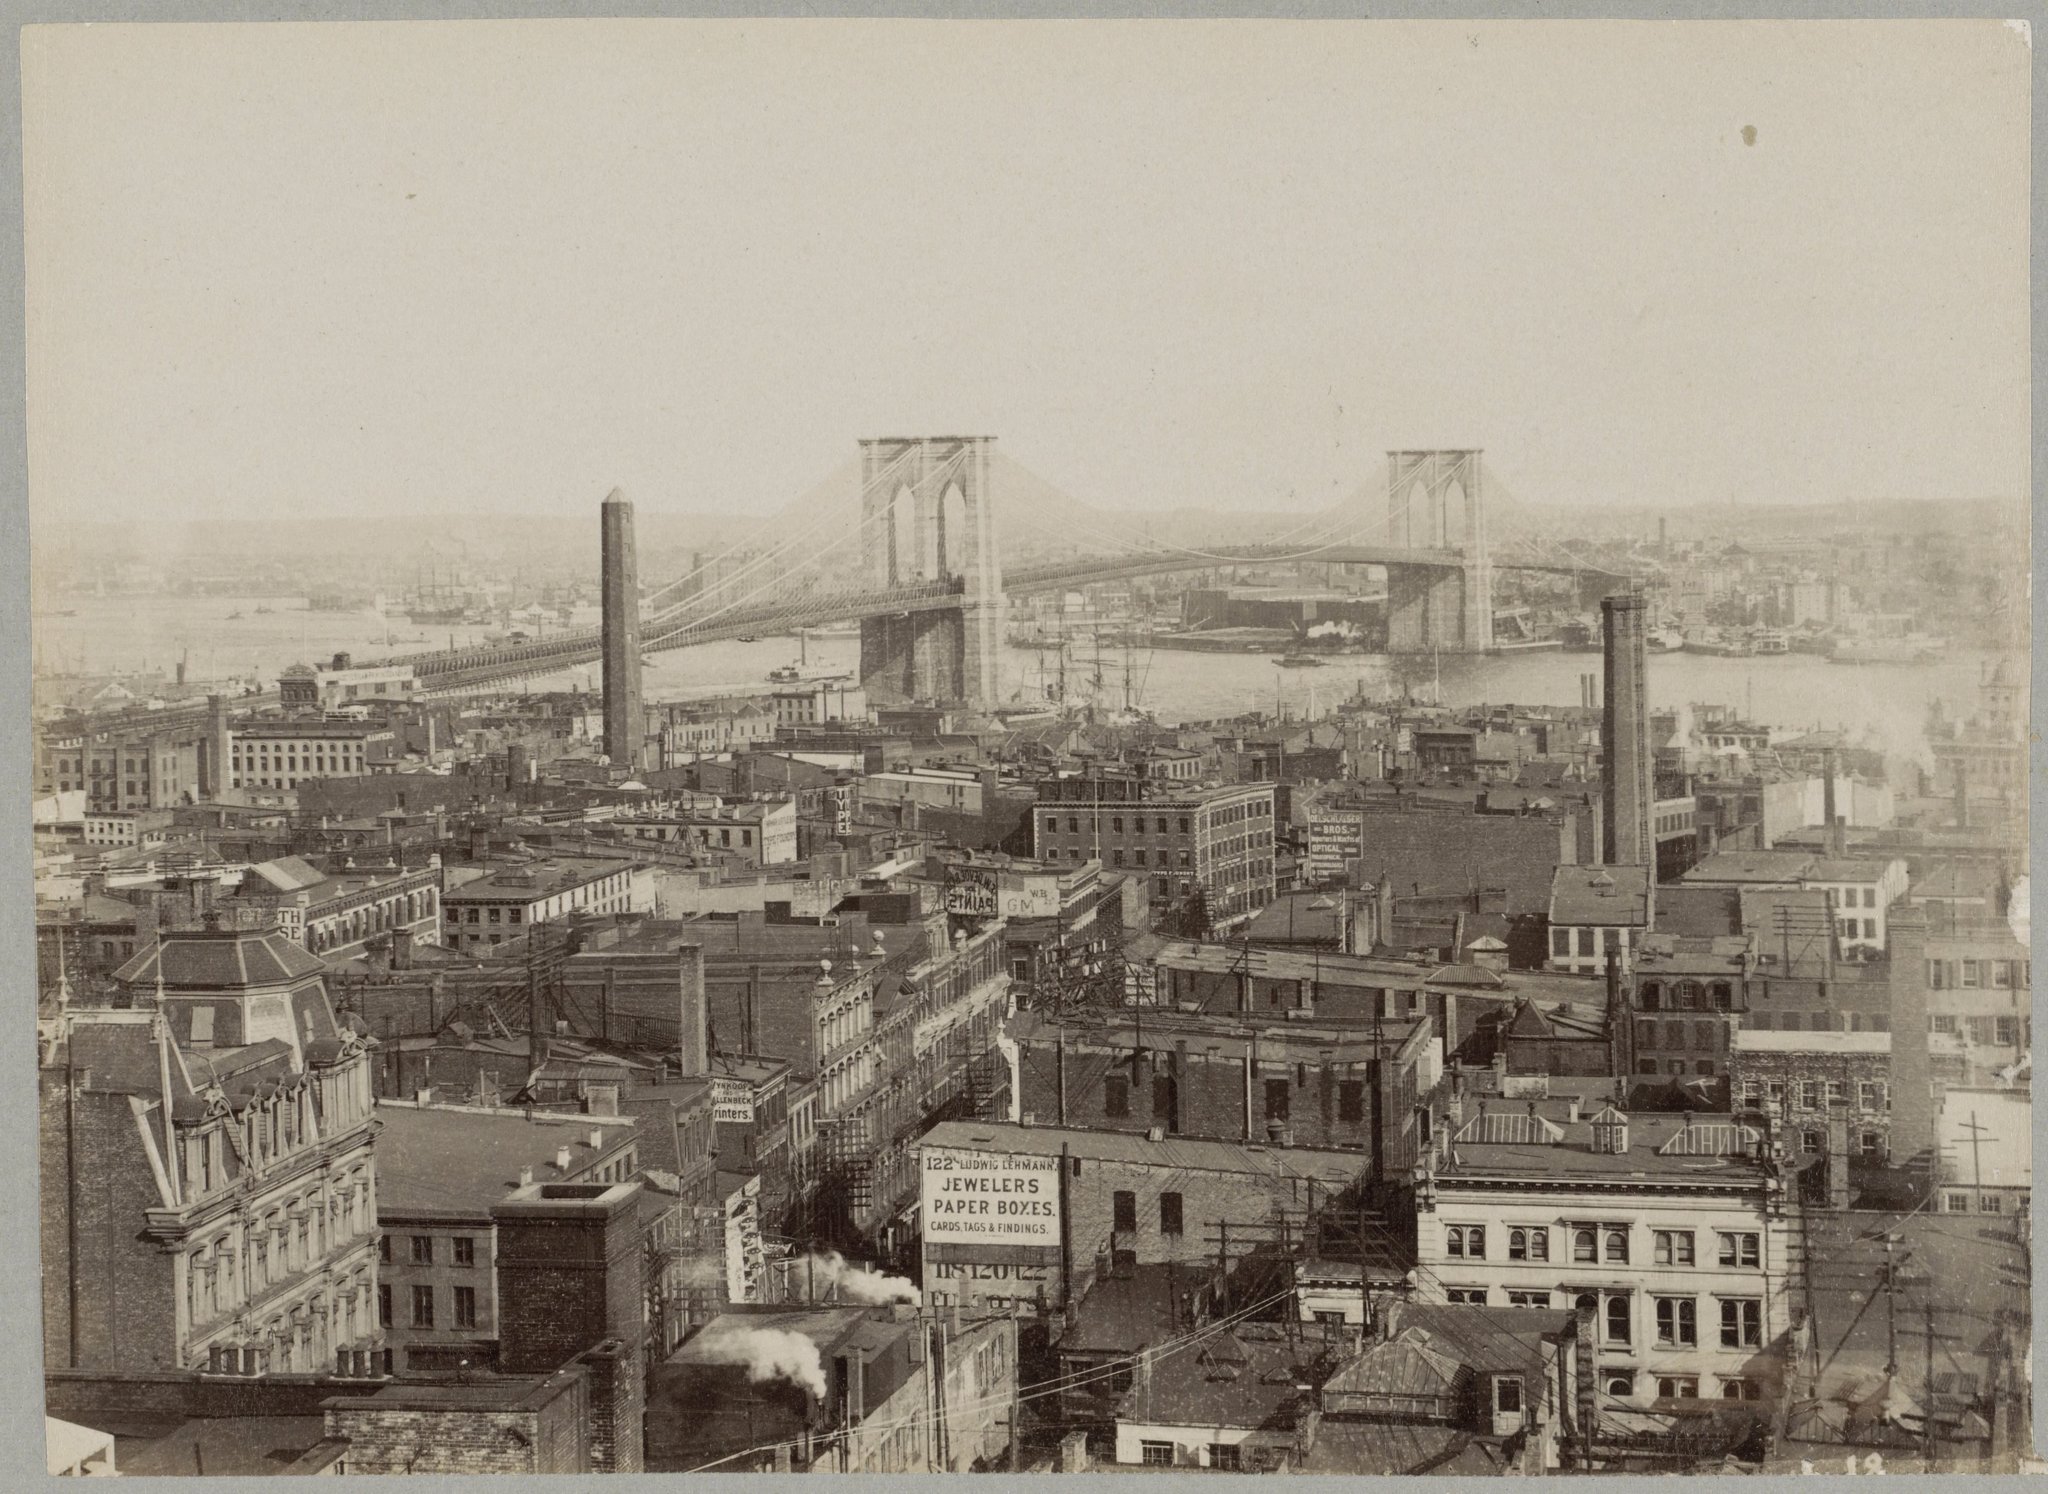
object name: photograph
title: Gezicht op New York en Brooklyn Bridge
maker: Anonymous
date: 1883-1900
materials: cardboard, paper, photographic support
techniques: albumen print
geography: new york city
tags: bridge in city across river, canal, etc., new york (city)